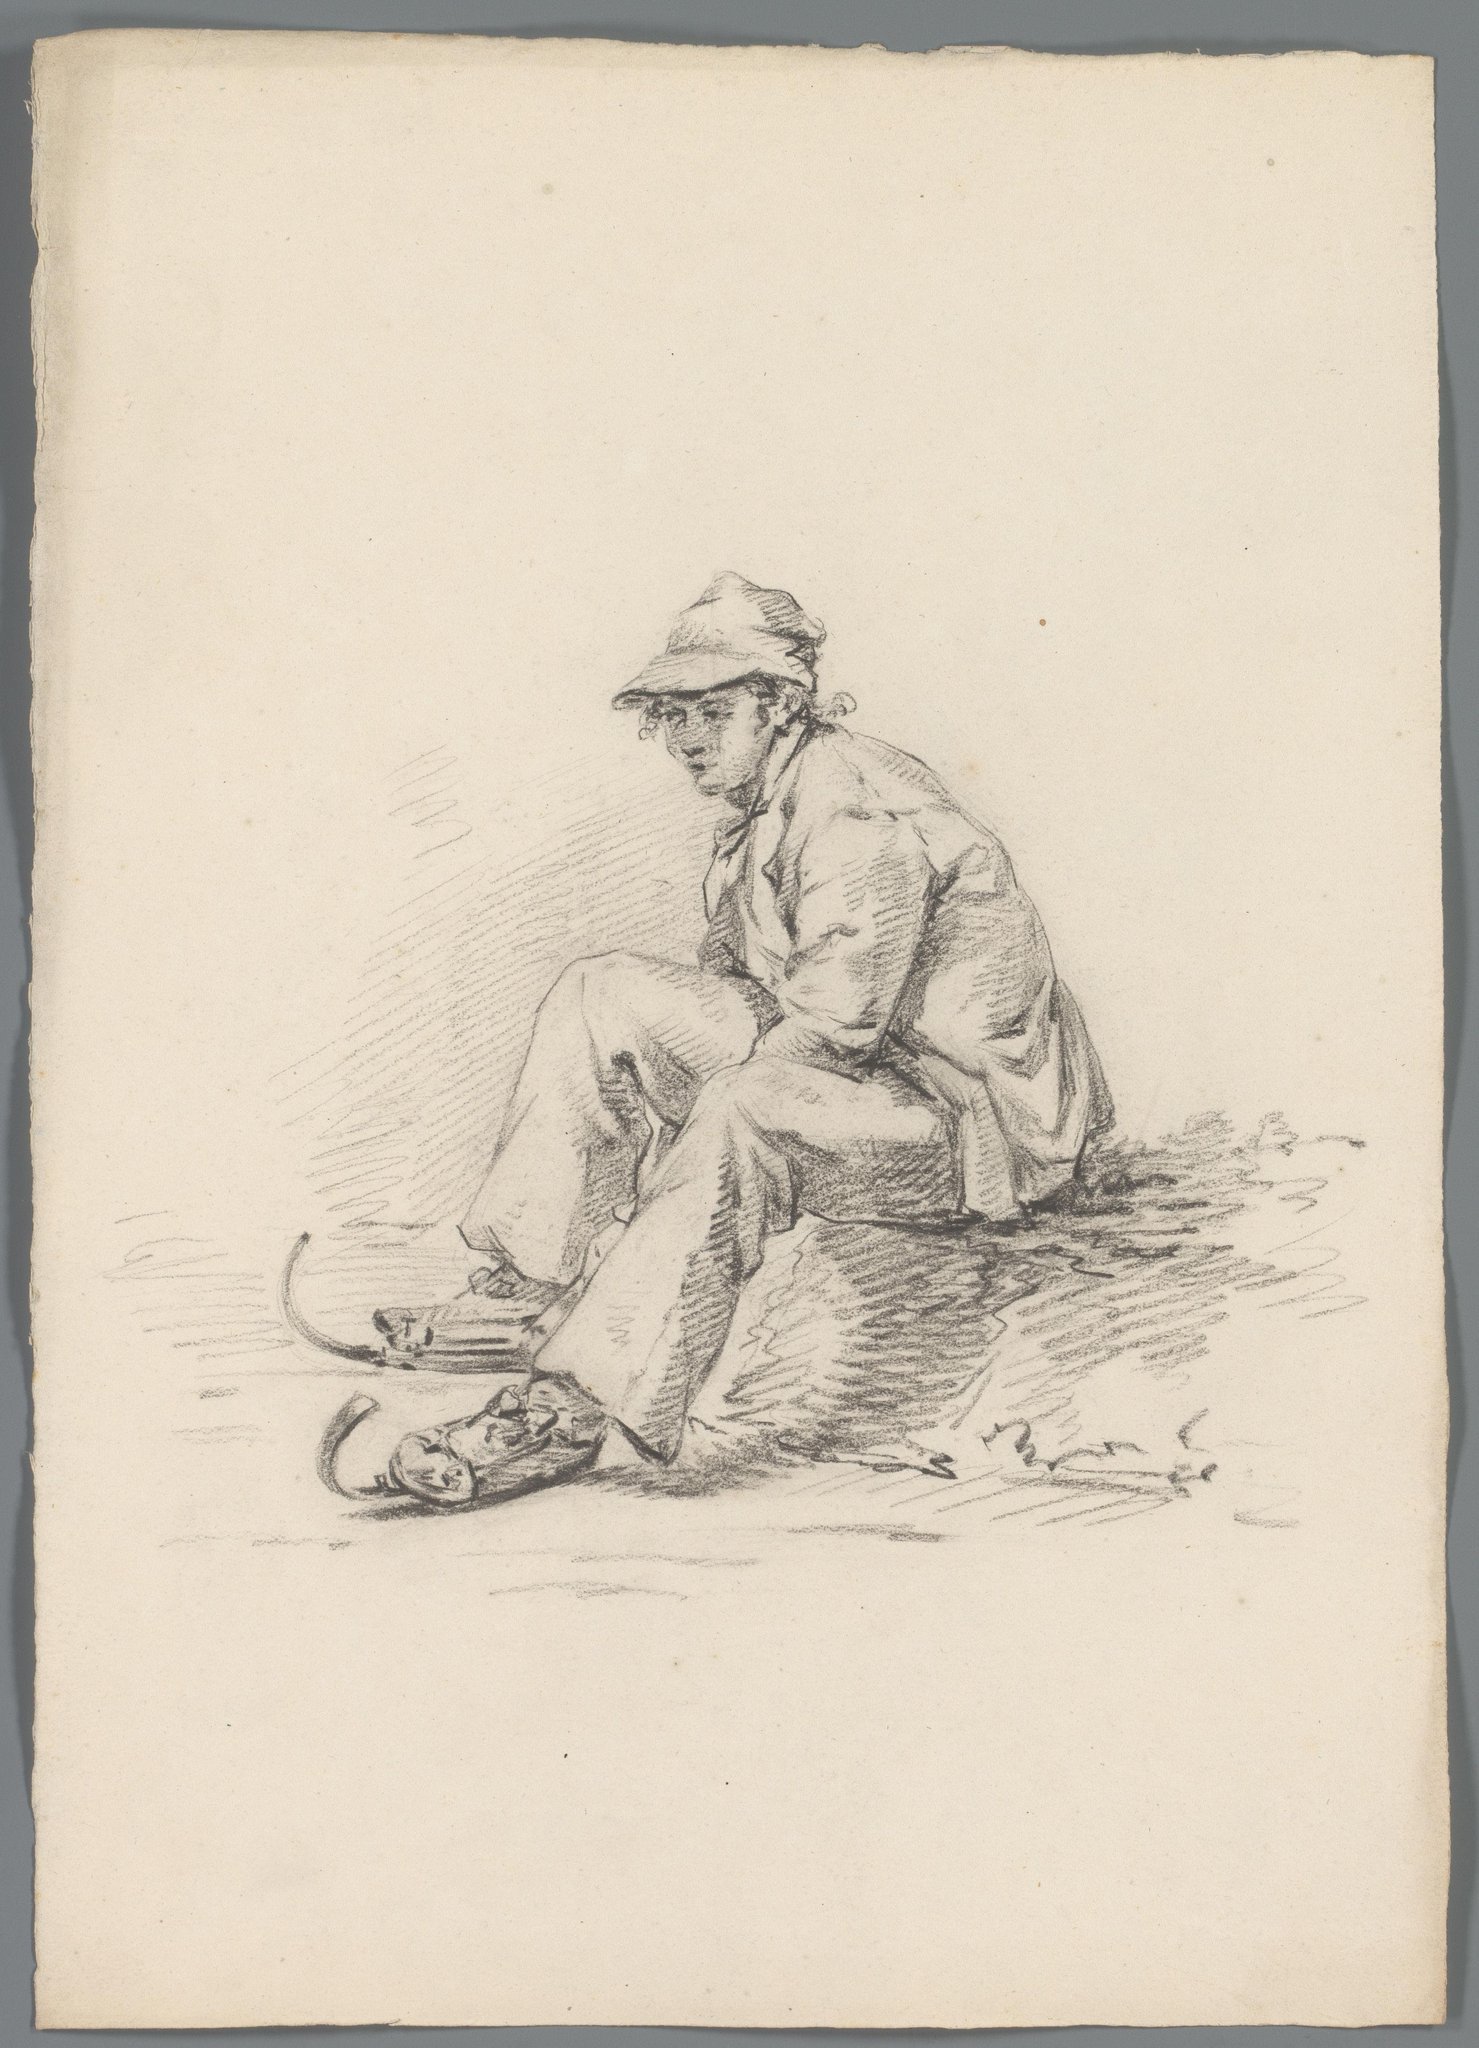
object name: drawing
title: Zittende man met schaatsen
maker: Anonymous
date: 1820-1830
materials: chalk, paper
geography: the hague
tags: sitting figure, adult woman, skates (winter sports)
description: Tekeningen waarschijnlijk ontstaan bij het Haagse kunstgenootschap ‘Tot Nut der Tekenkunst’, waar twee keer per week tekenavonden werden georganiseerd met geklede modellen.